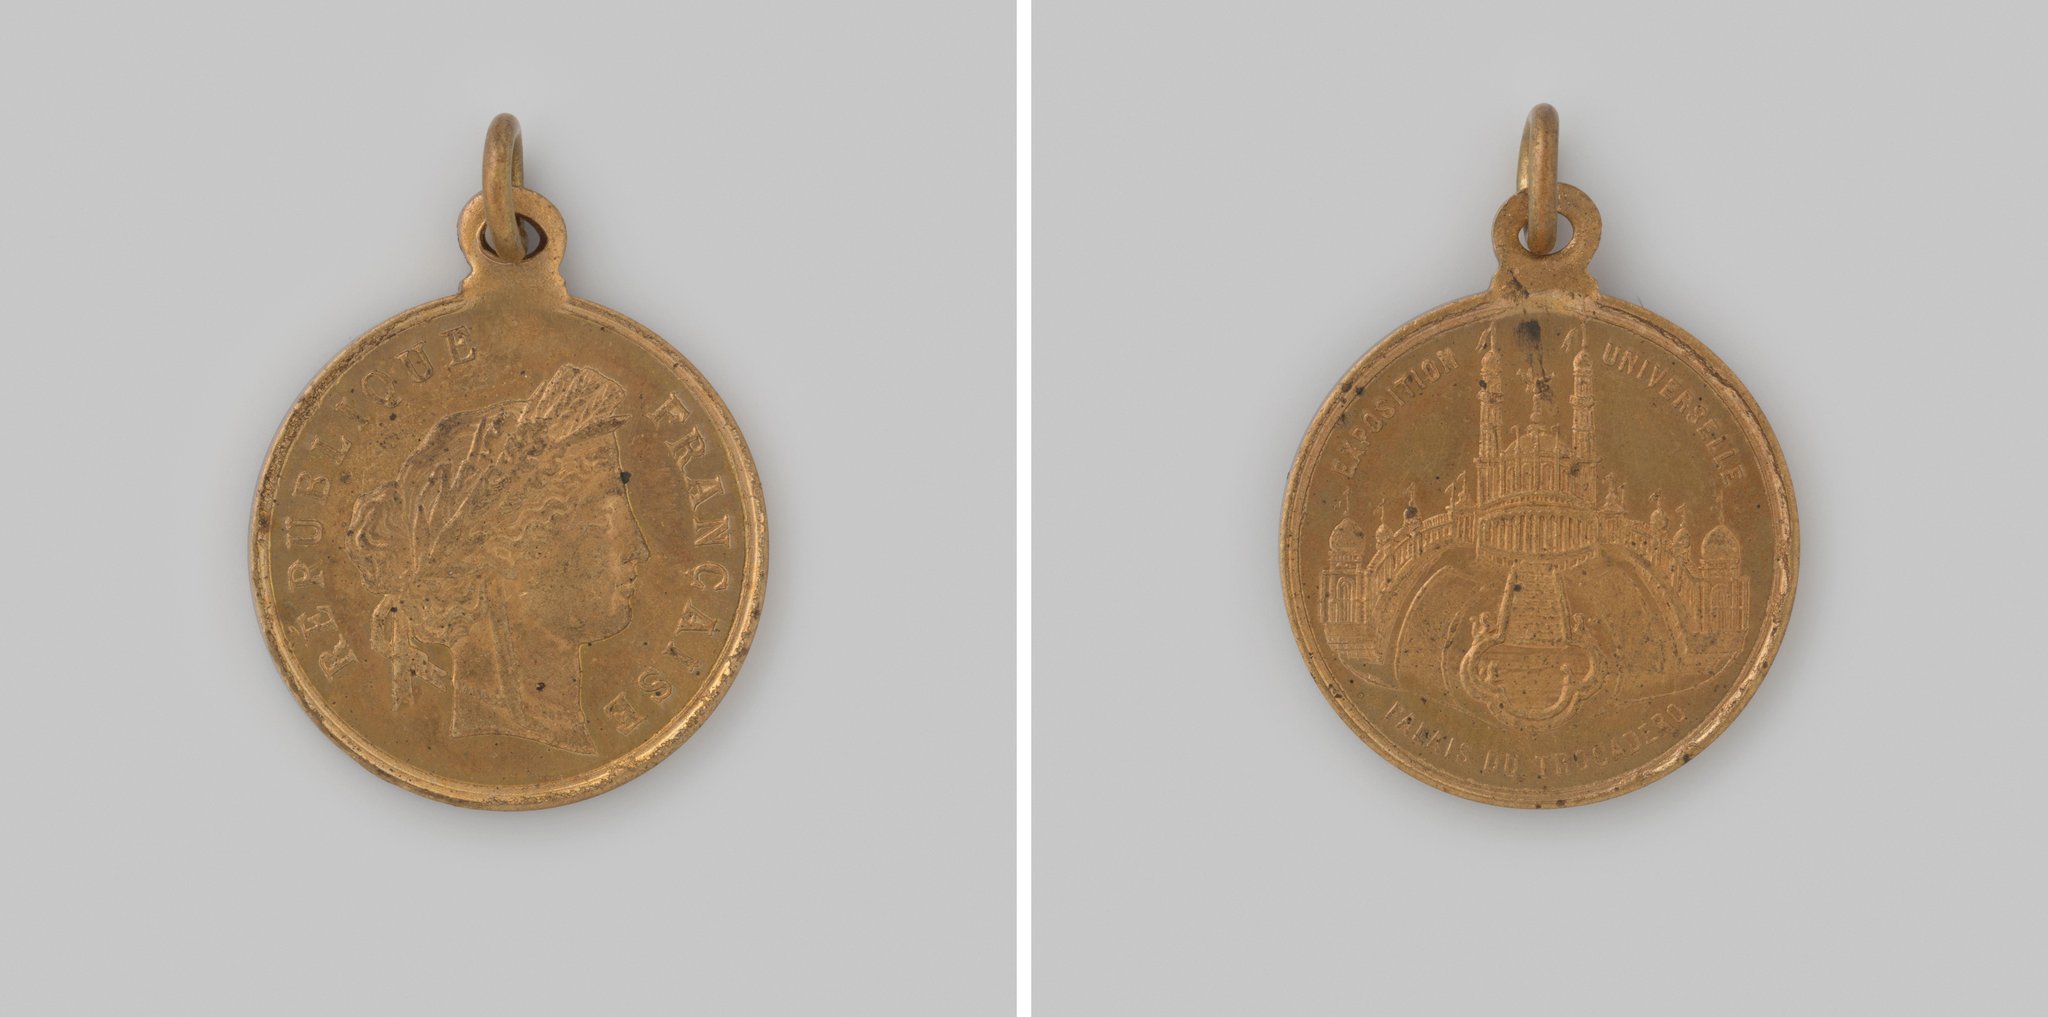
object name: history medal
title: Wereldtentoonstelling in het Palais du Trocadero te Parijs 1878 ?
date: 1878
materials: brass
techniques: striking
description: Vergulde penning met oog en draagring, op de voorzijde het portret van Ceres naar rechts met omschrift, op de keerzijde een afbeelding van het Palais de Trocadero met omschrift.